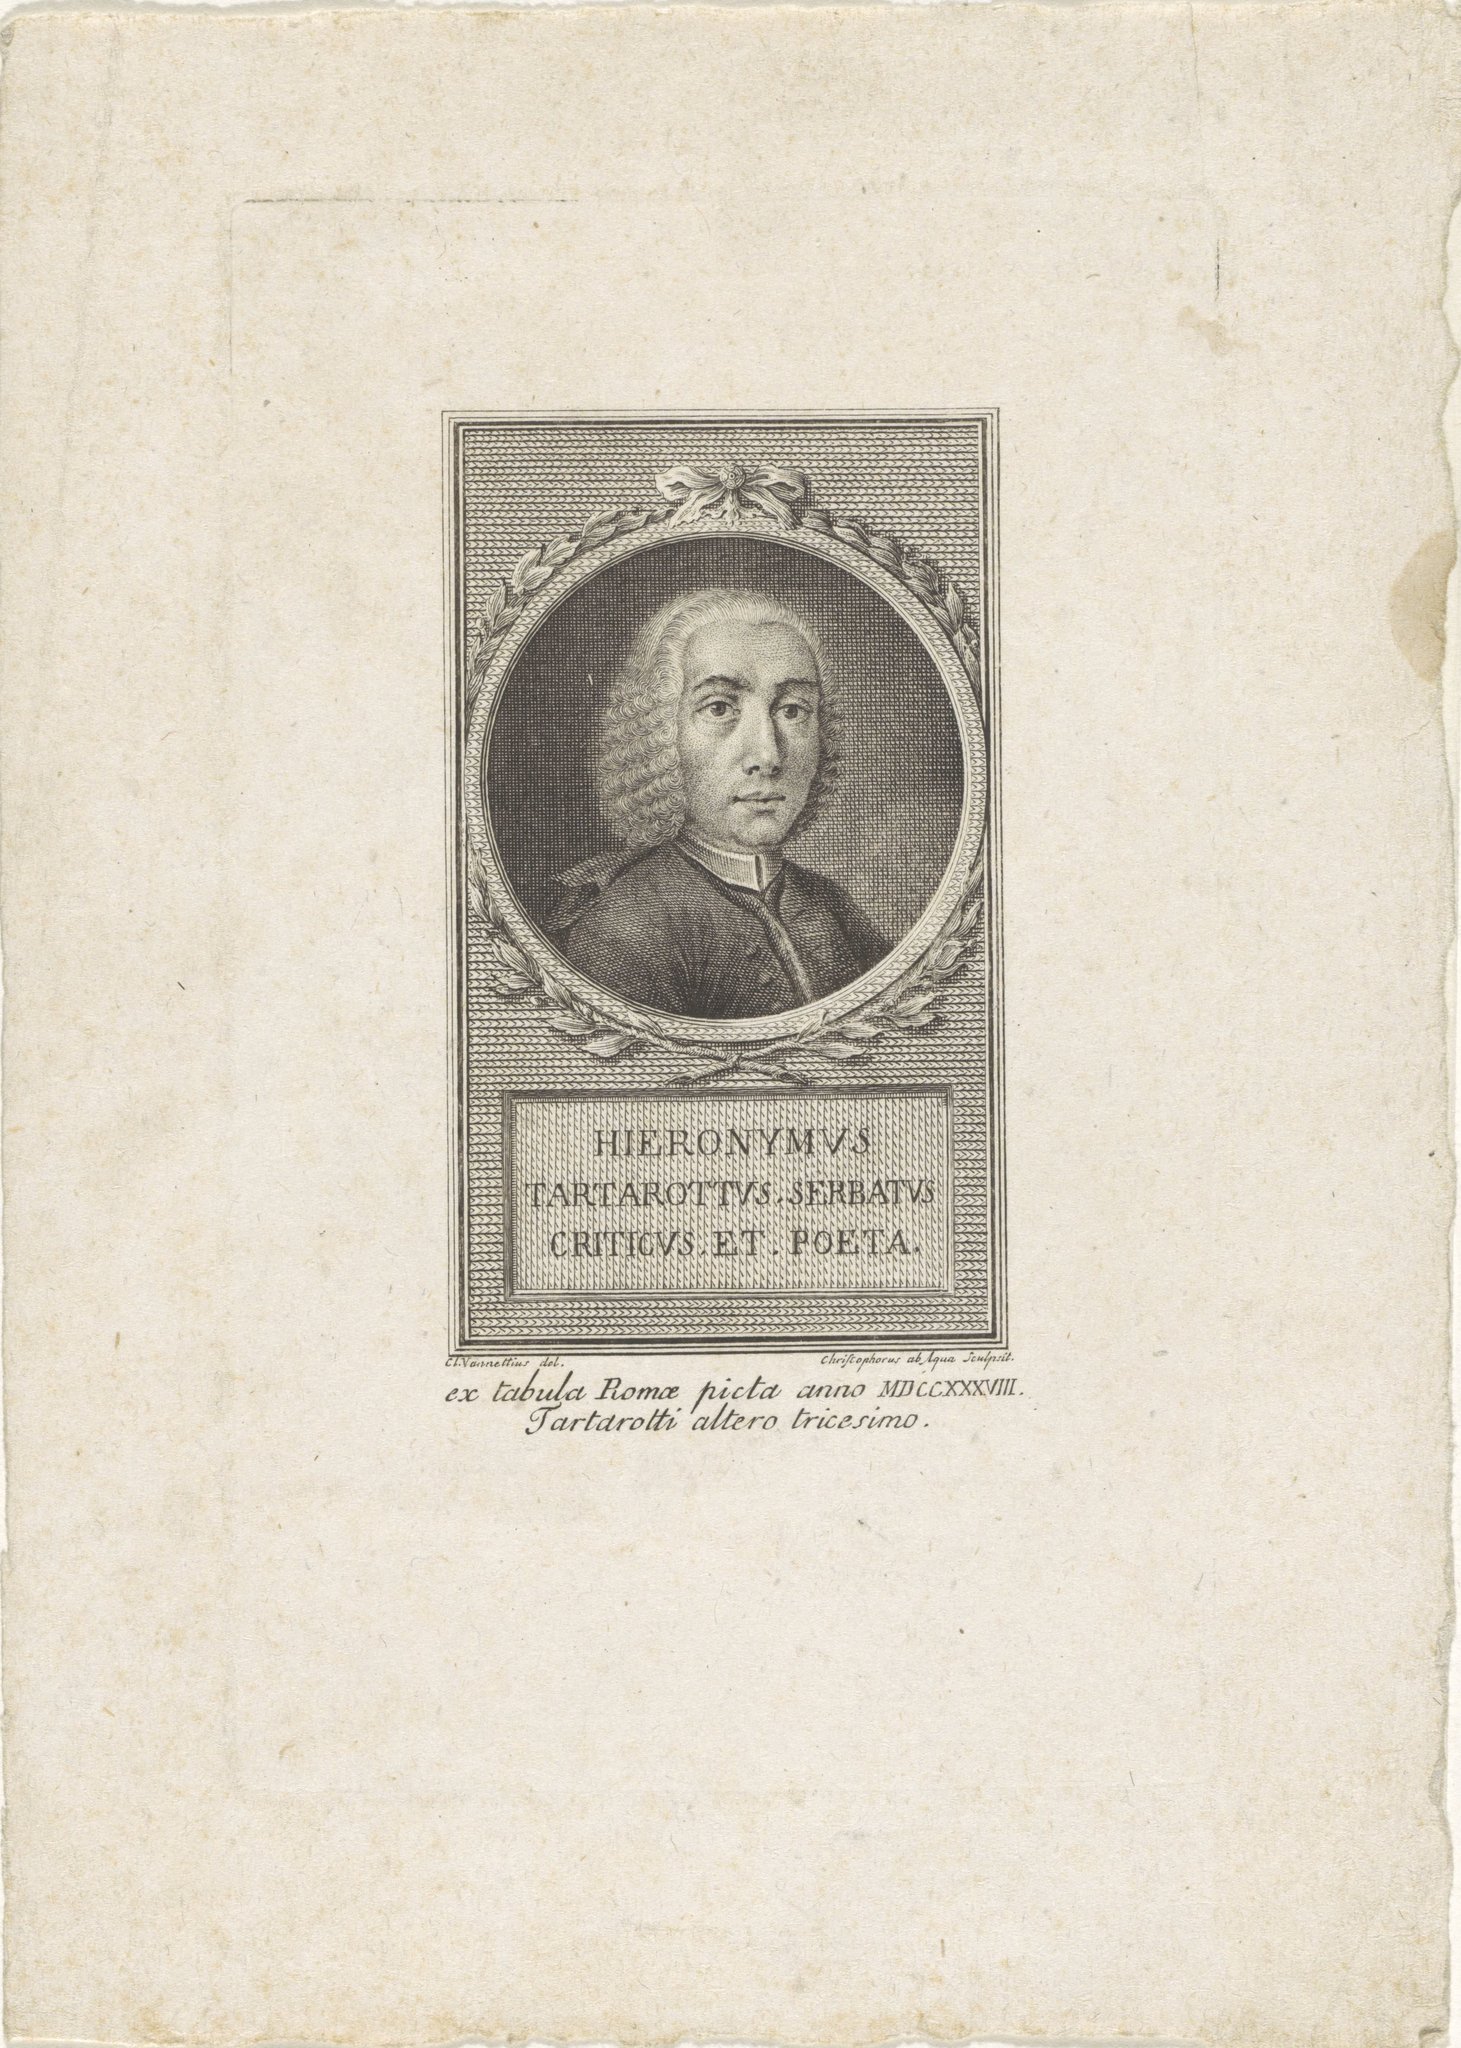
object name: print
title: Portret van Girolamo Tartaròtti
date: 1738-1787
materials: paper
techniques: engraving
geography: italy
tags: portrait of a writer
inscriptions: collector's mark: Lugt 2228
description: Portret van schrijver Girolamo Tartaròtti in een cirkelvormige lijst met laurierbladeren. Op een plaquette onder het portret zijn naam. In de ondermarge twee regels Italiaanse tekst.